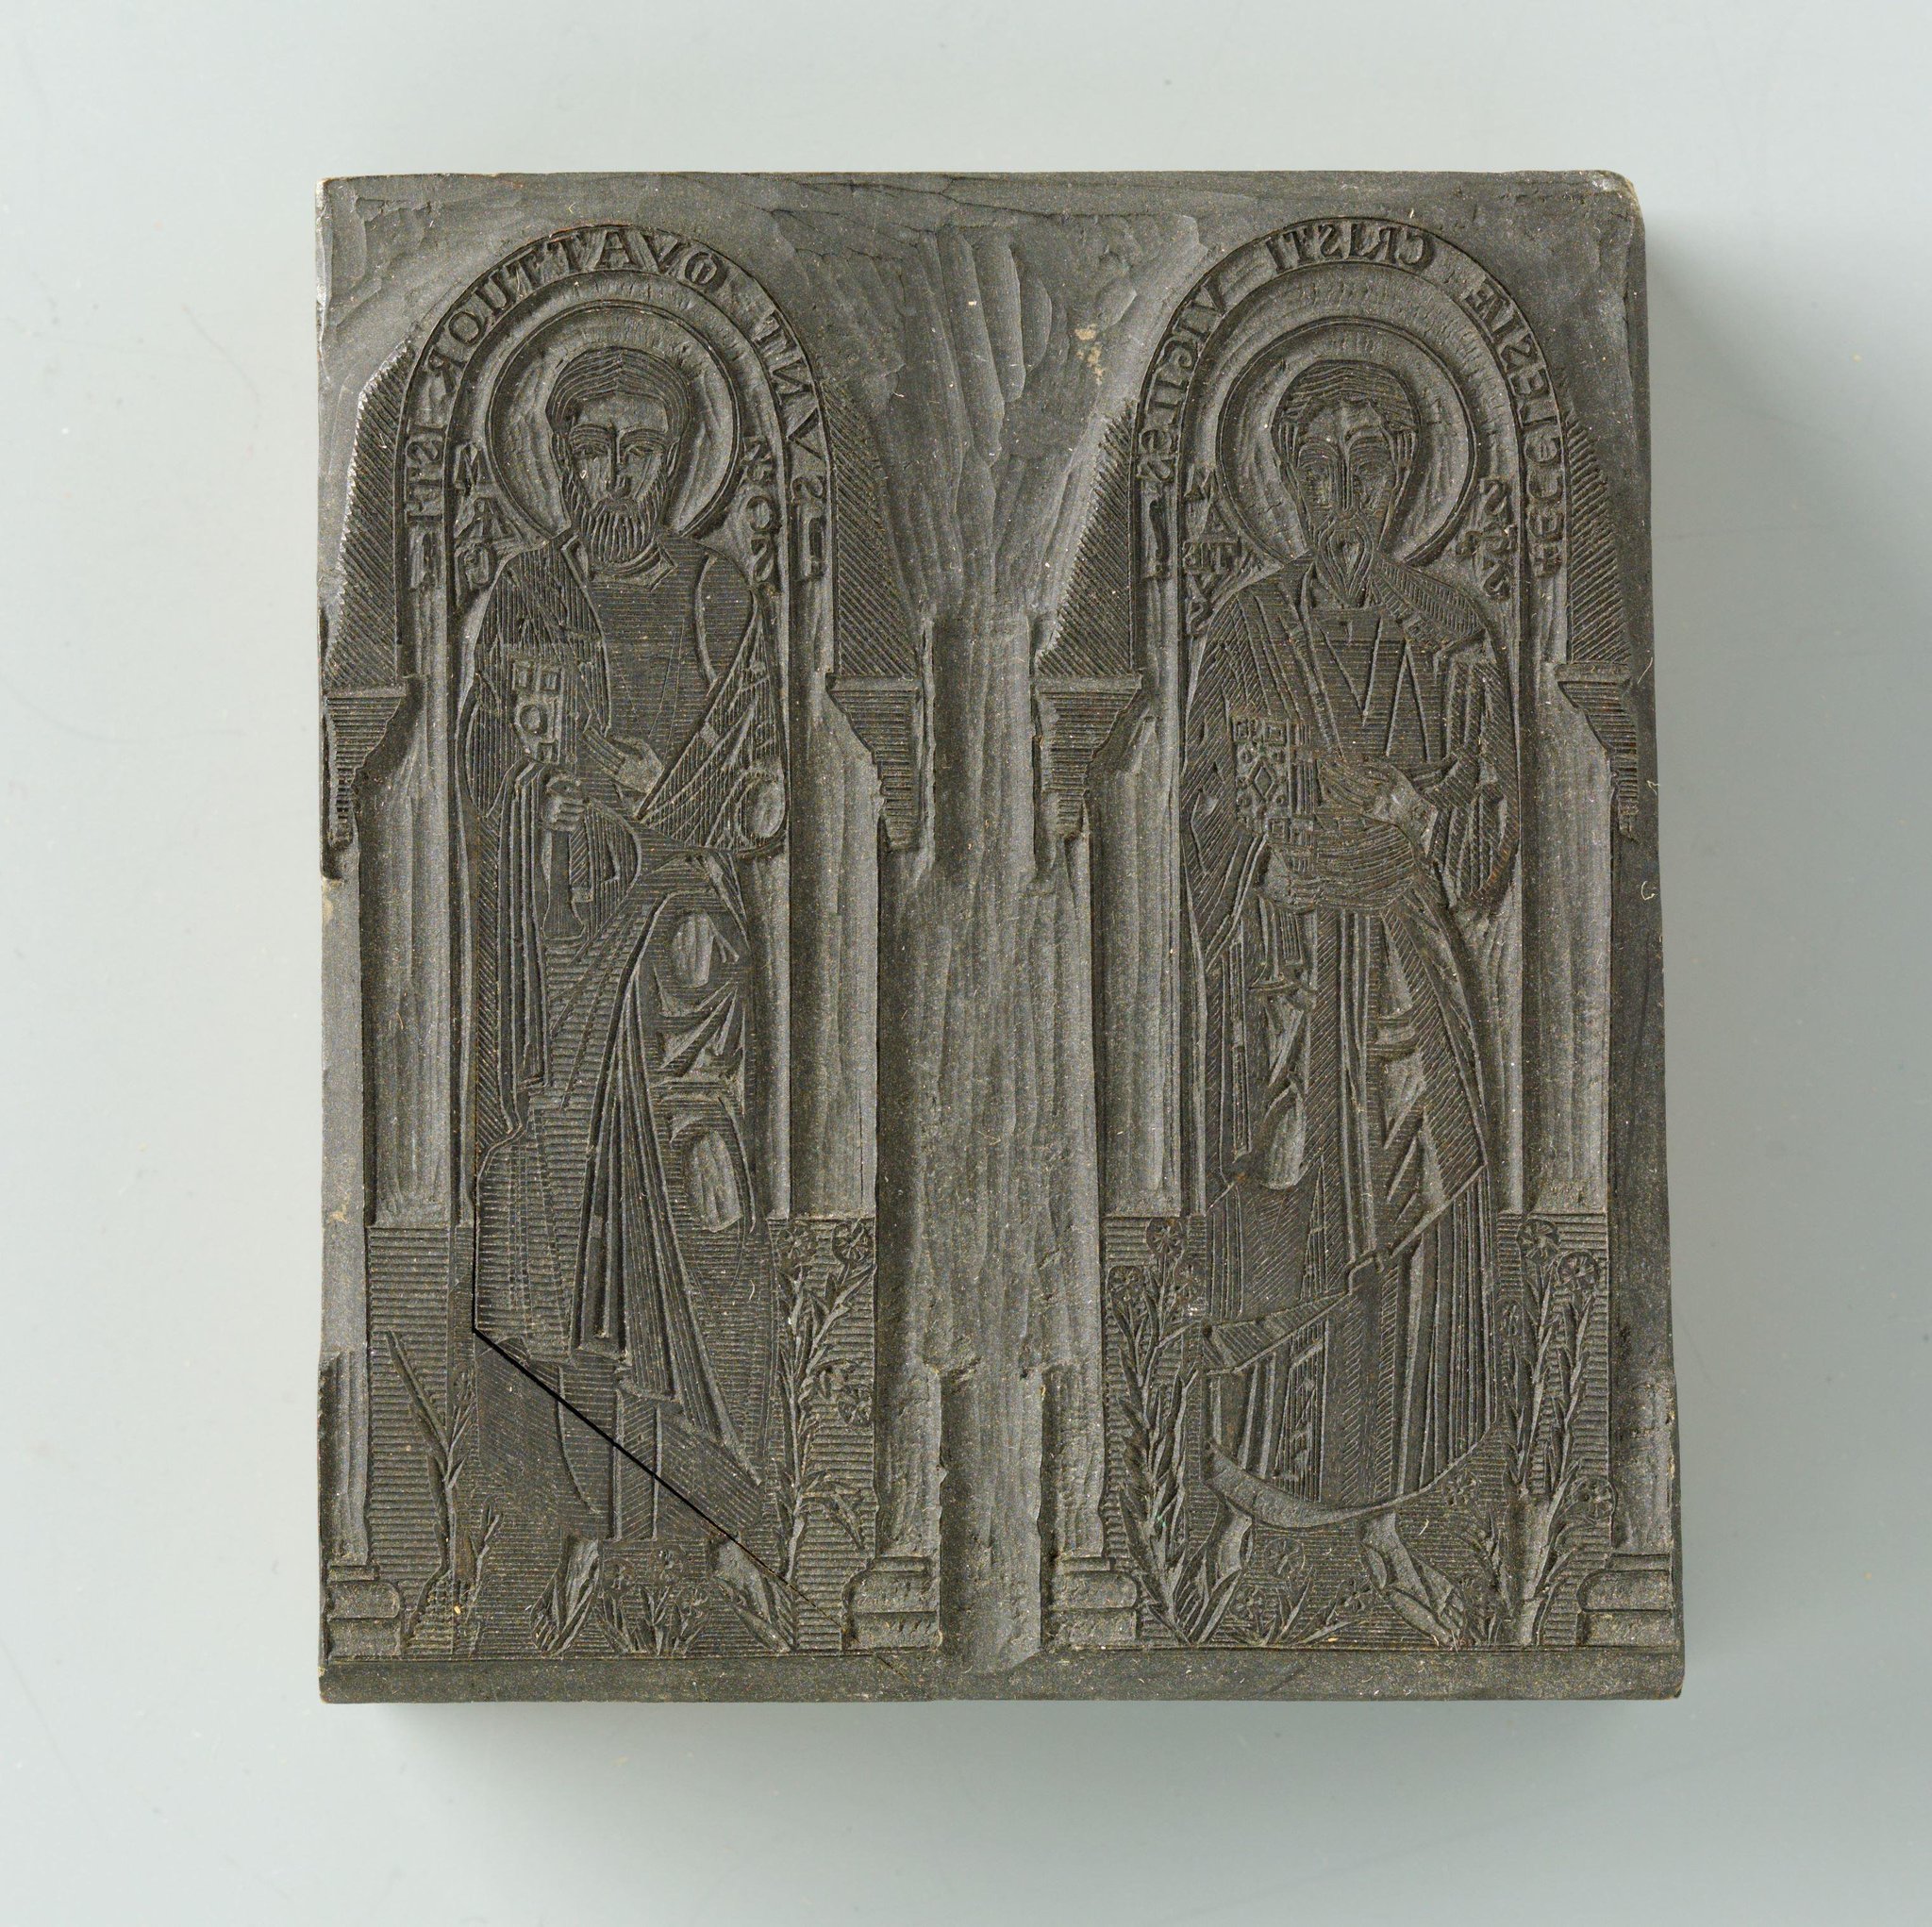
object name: wood block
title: Marcus en Mattheus, ieder in een nis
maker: Anonymous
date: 1800-1899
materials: wood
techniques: engraving